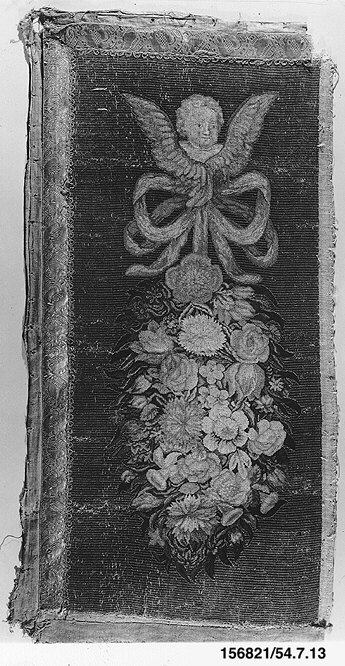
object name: panel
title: Pair of panels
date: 1701-1750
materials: canvas, metal thread, silk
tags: faces,flowers,leaves